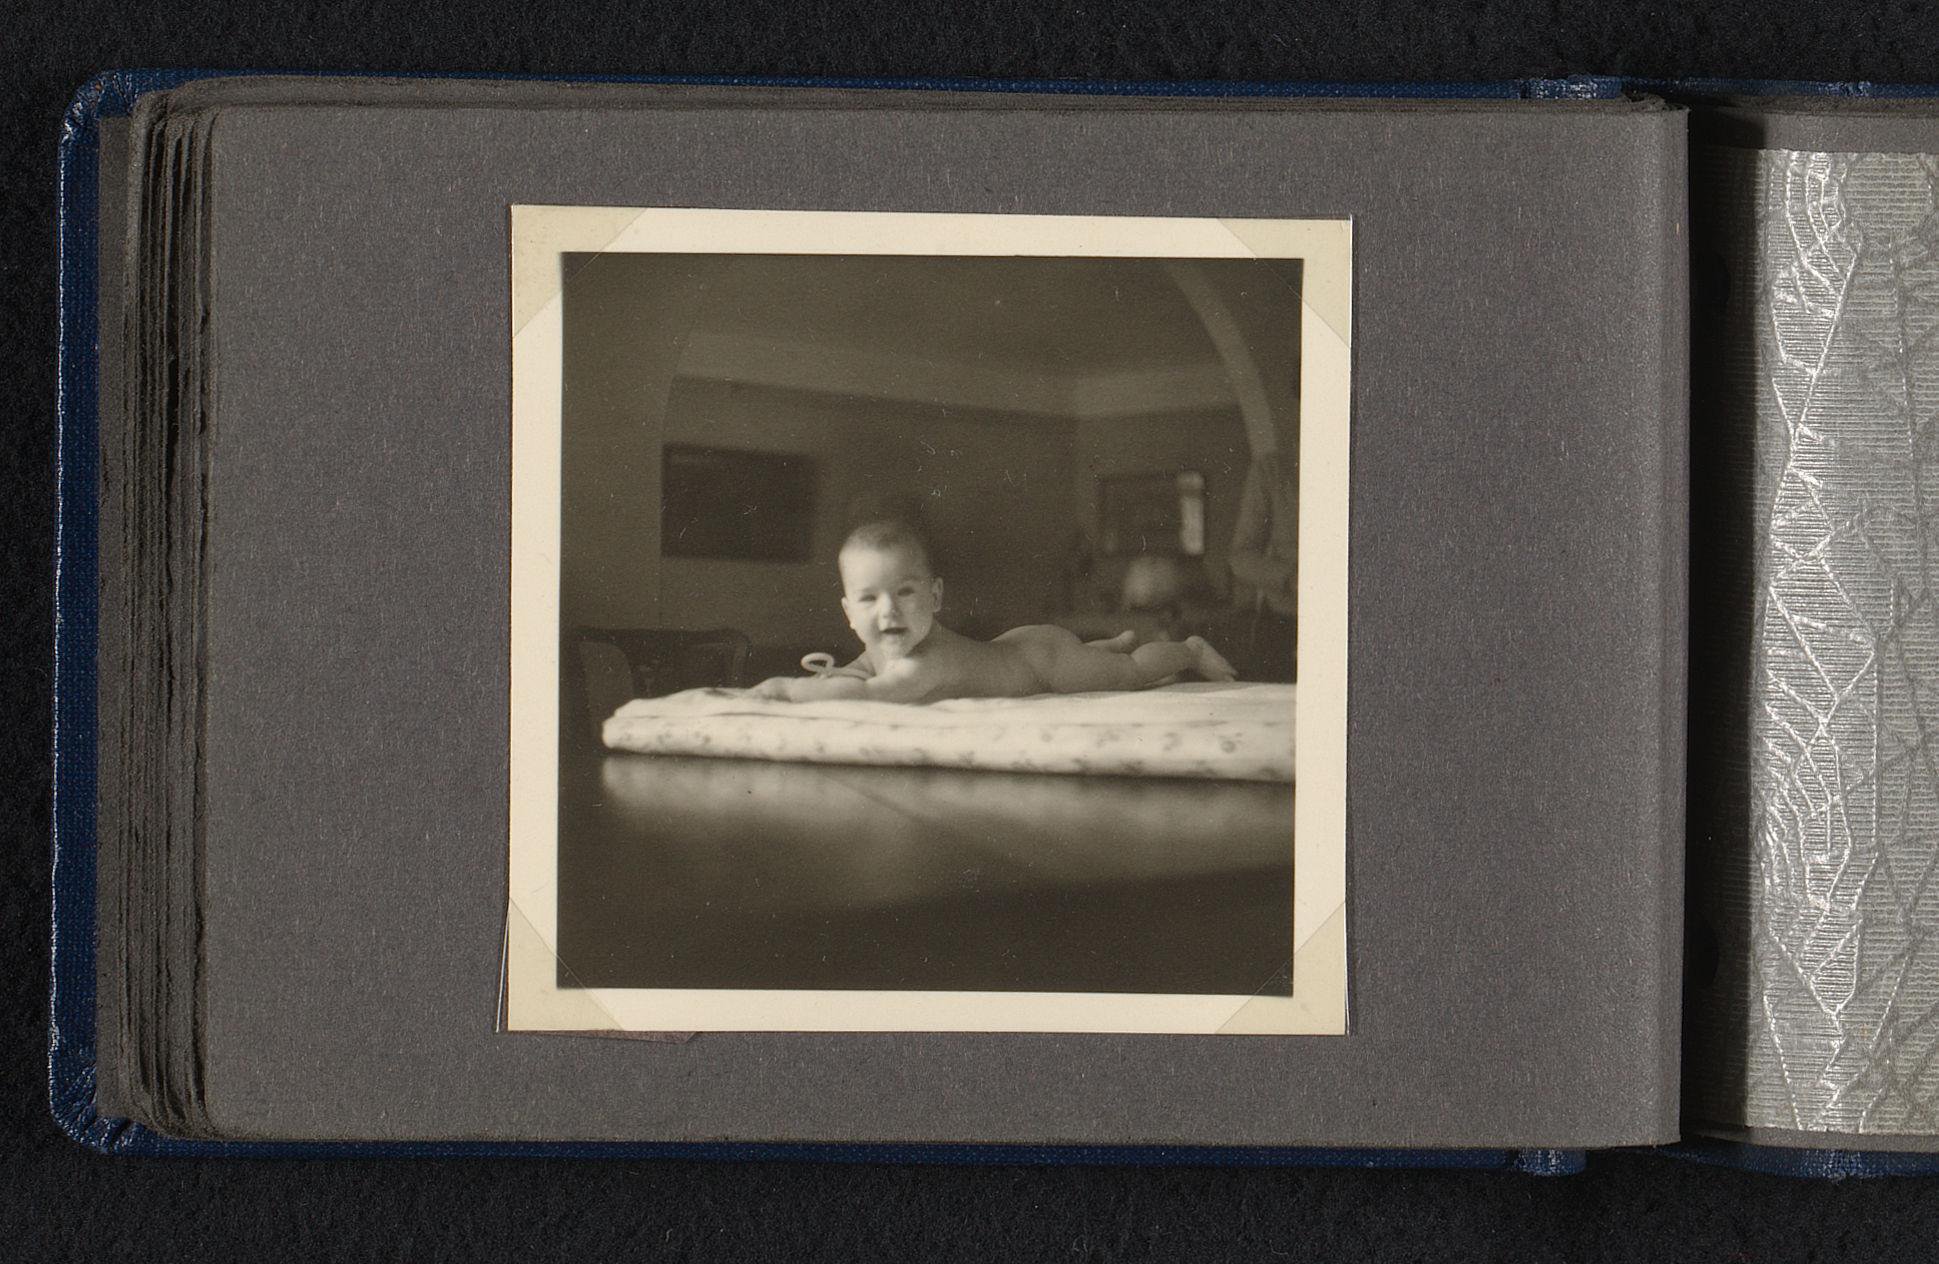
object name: album leaf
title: Norbert Peter van den Berg als baby, liggend op de buik op een kleed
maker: norbert peter van den berg (1941-)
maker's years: 1941-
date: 1941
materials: paper, cardboard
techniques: gelatin silver print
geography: netherlands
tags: amsterdam, norbert peter van den berg (1941-), the (nude) human figure; 'corpo humano' (ripa), infant, baby